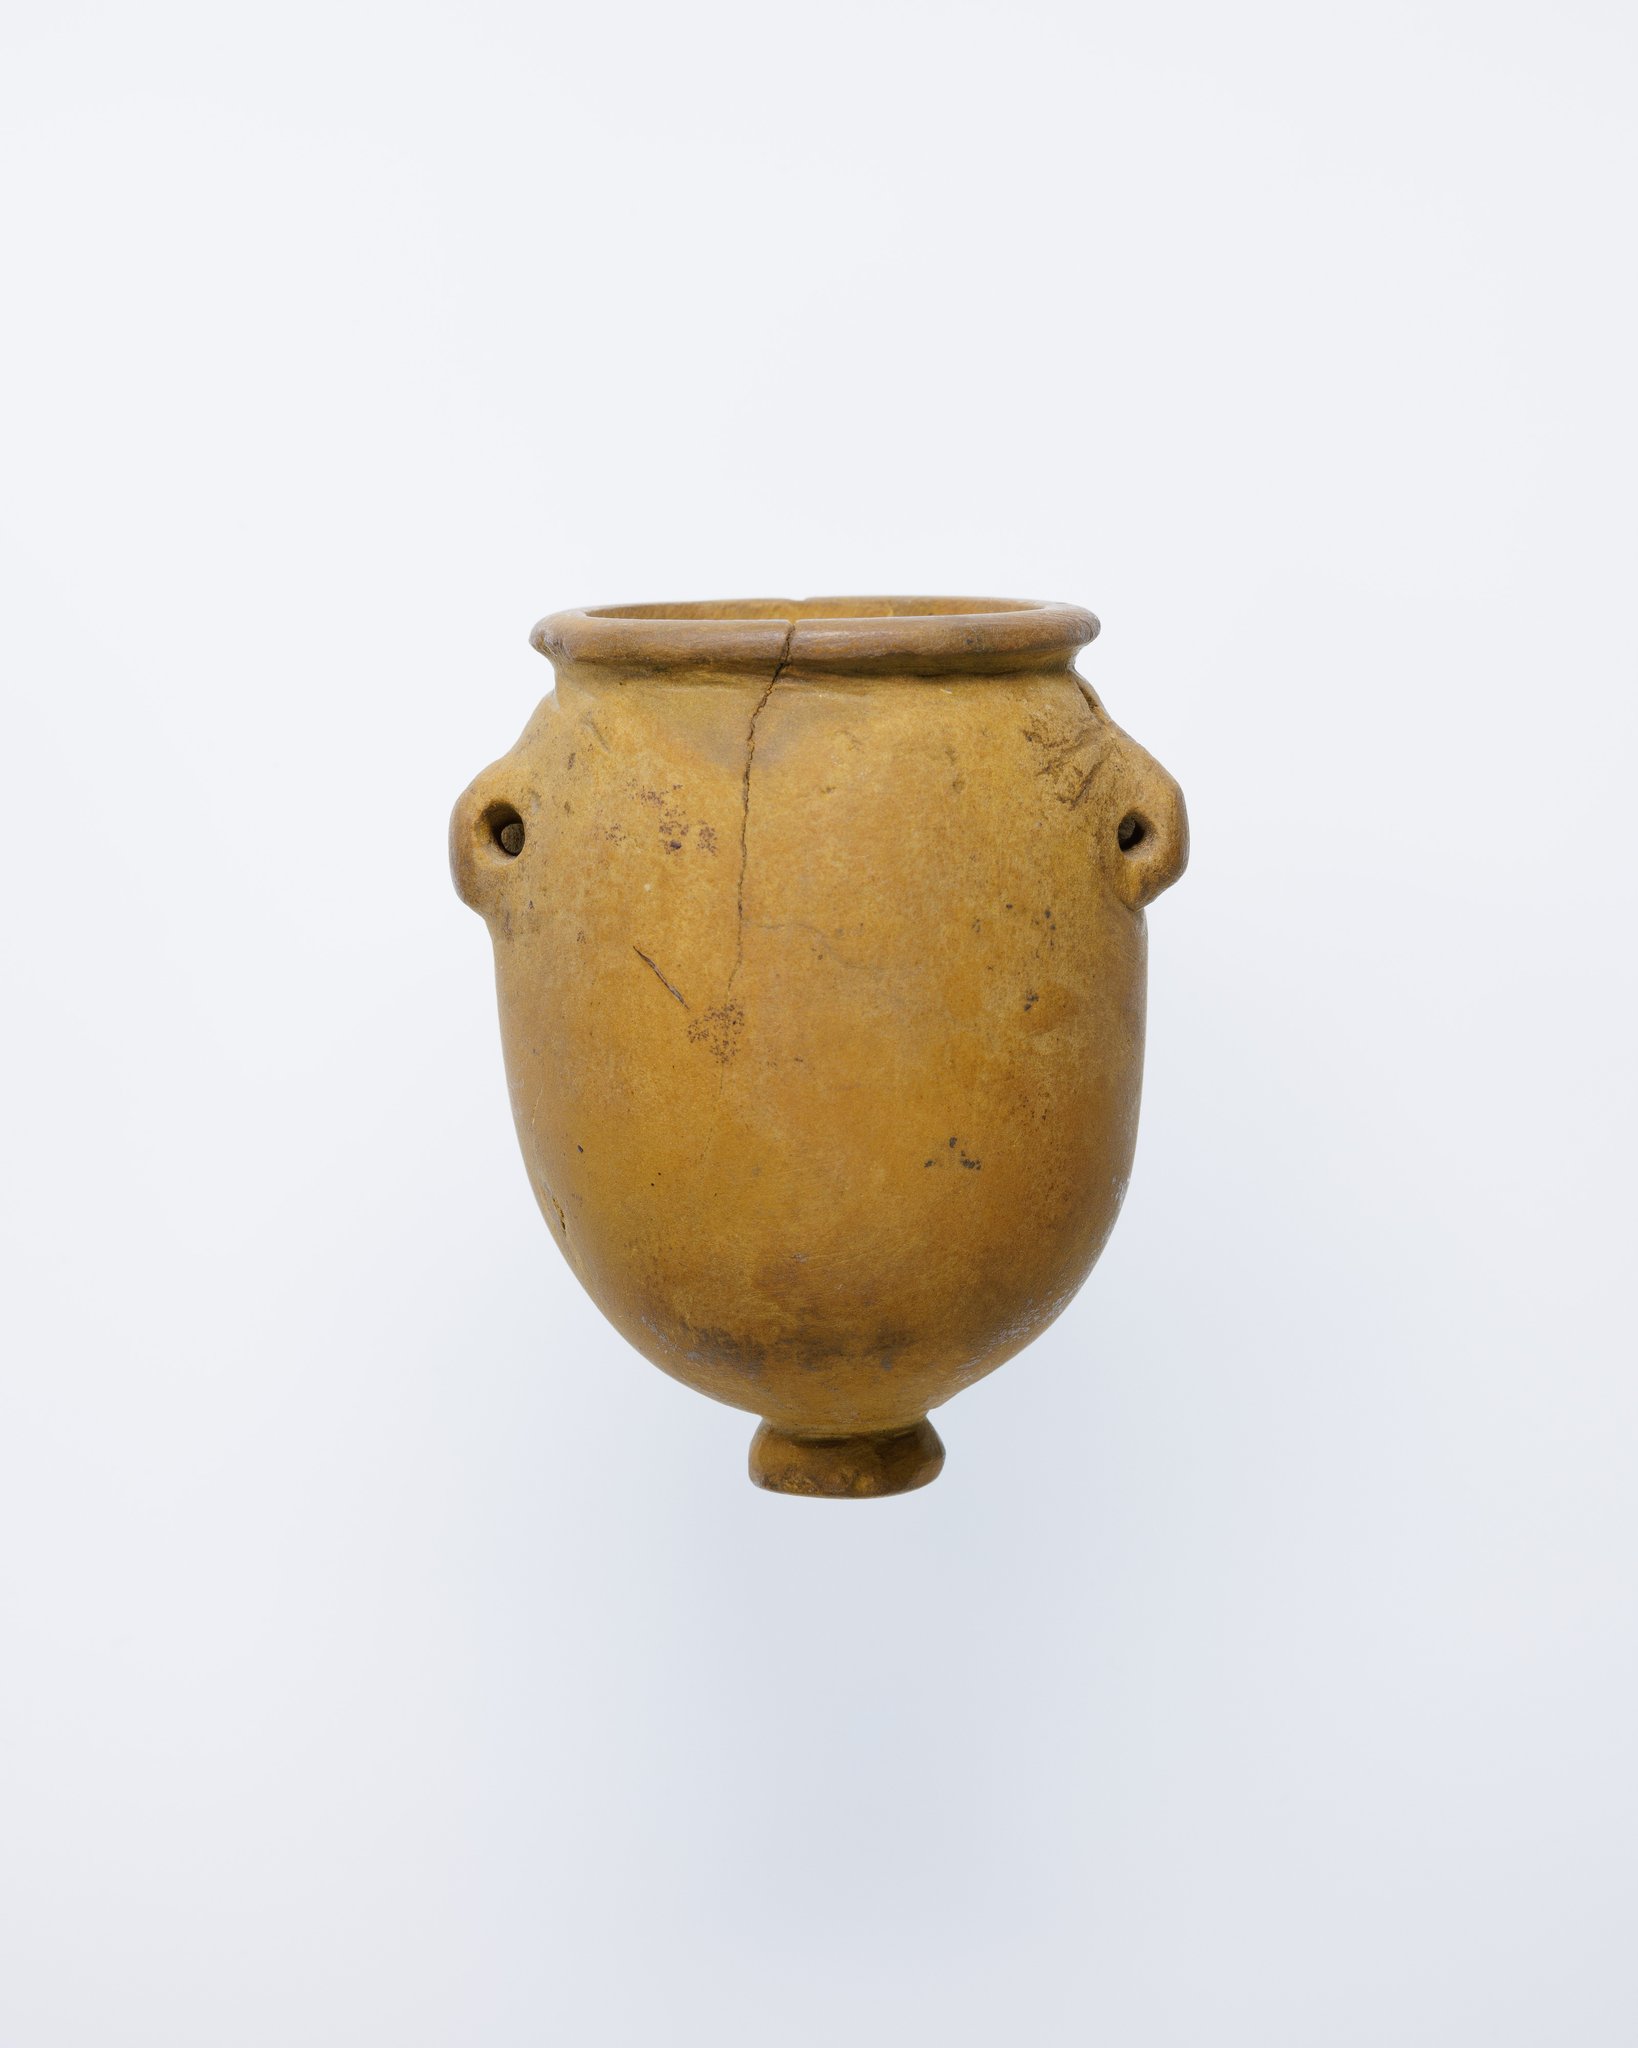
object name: jar, footed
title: Footed jar with lug handles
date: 3650-3500 BCE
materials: stone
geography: egypt